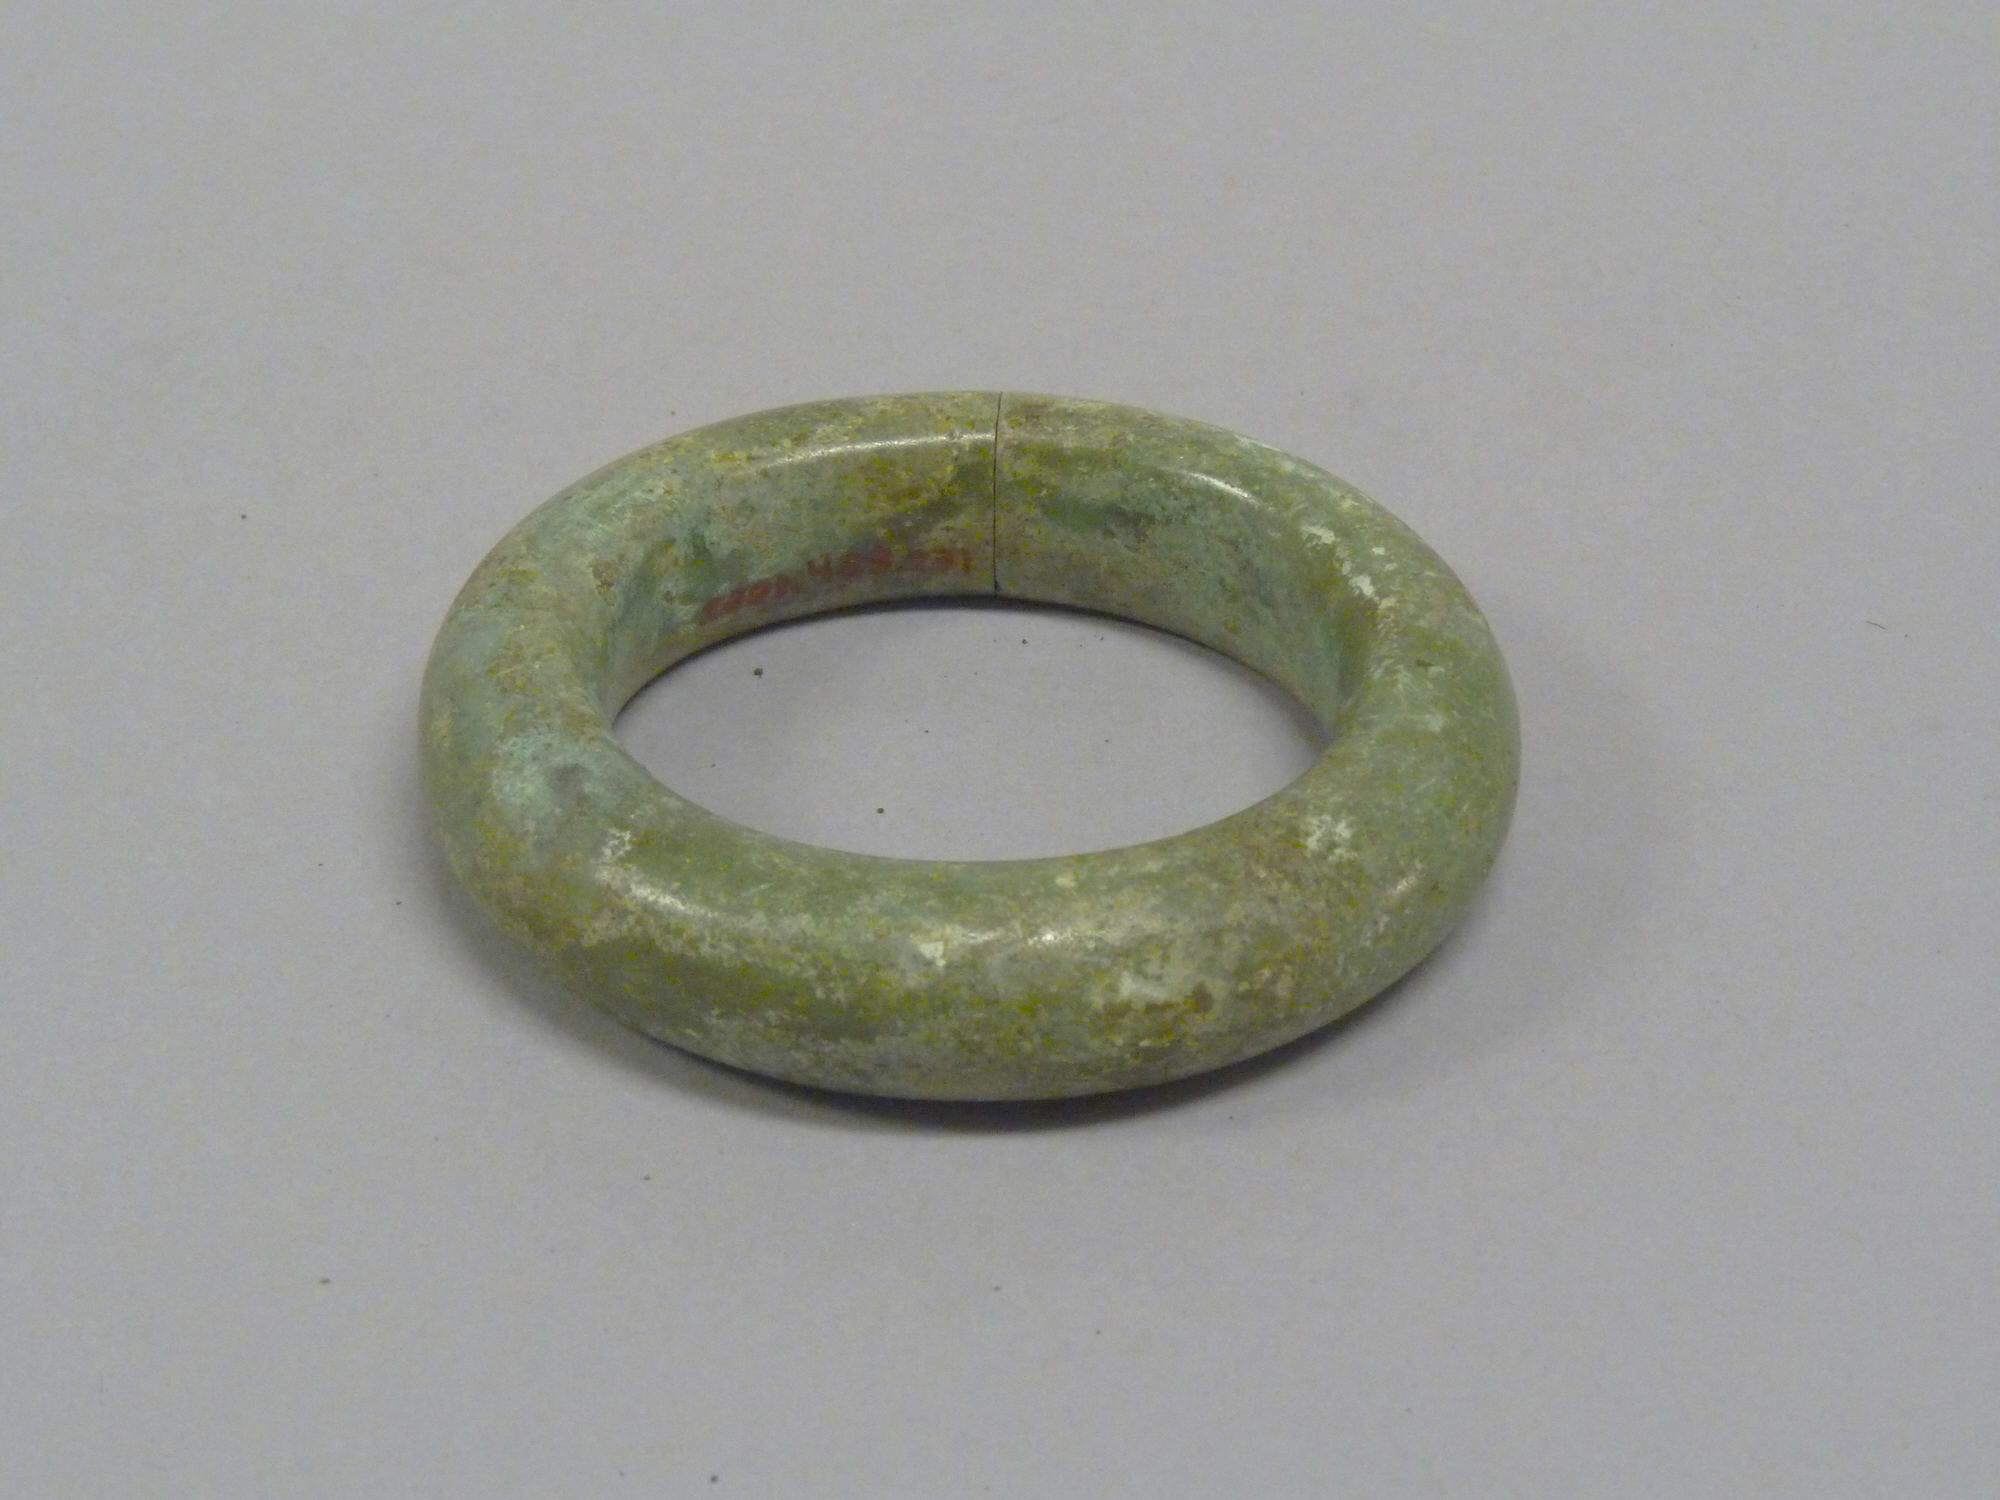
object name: bangle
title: Solid Bangle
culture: thai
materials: bronze